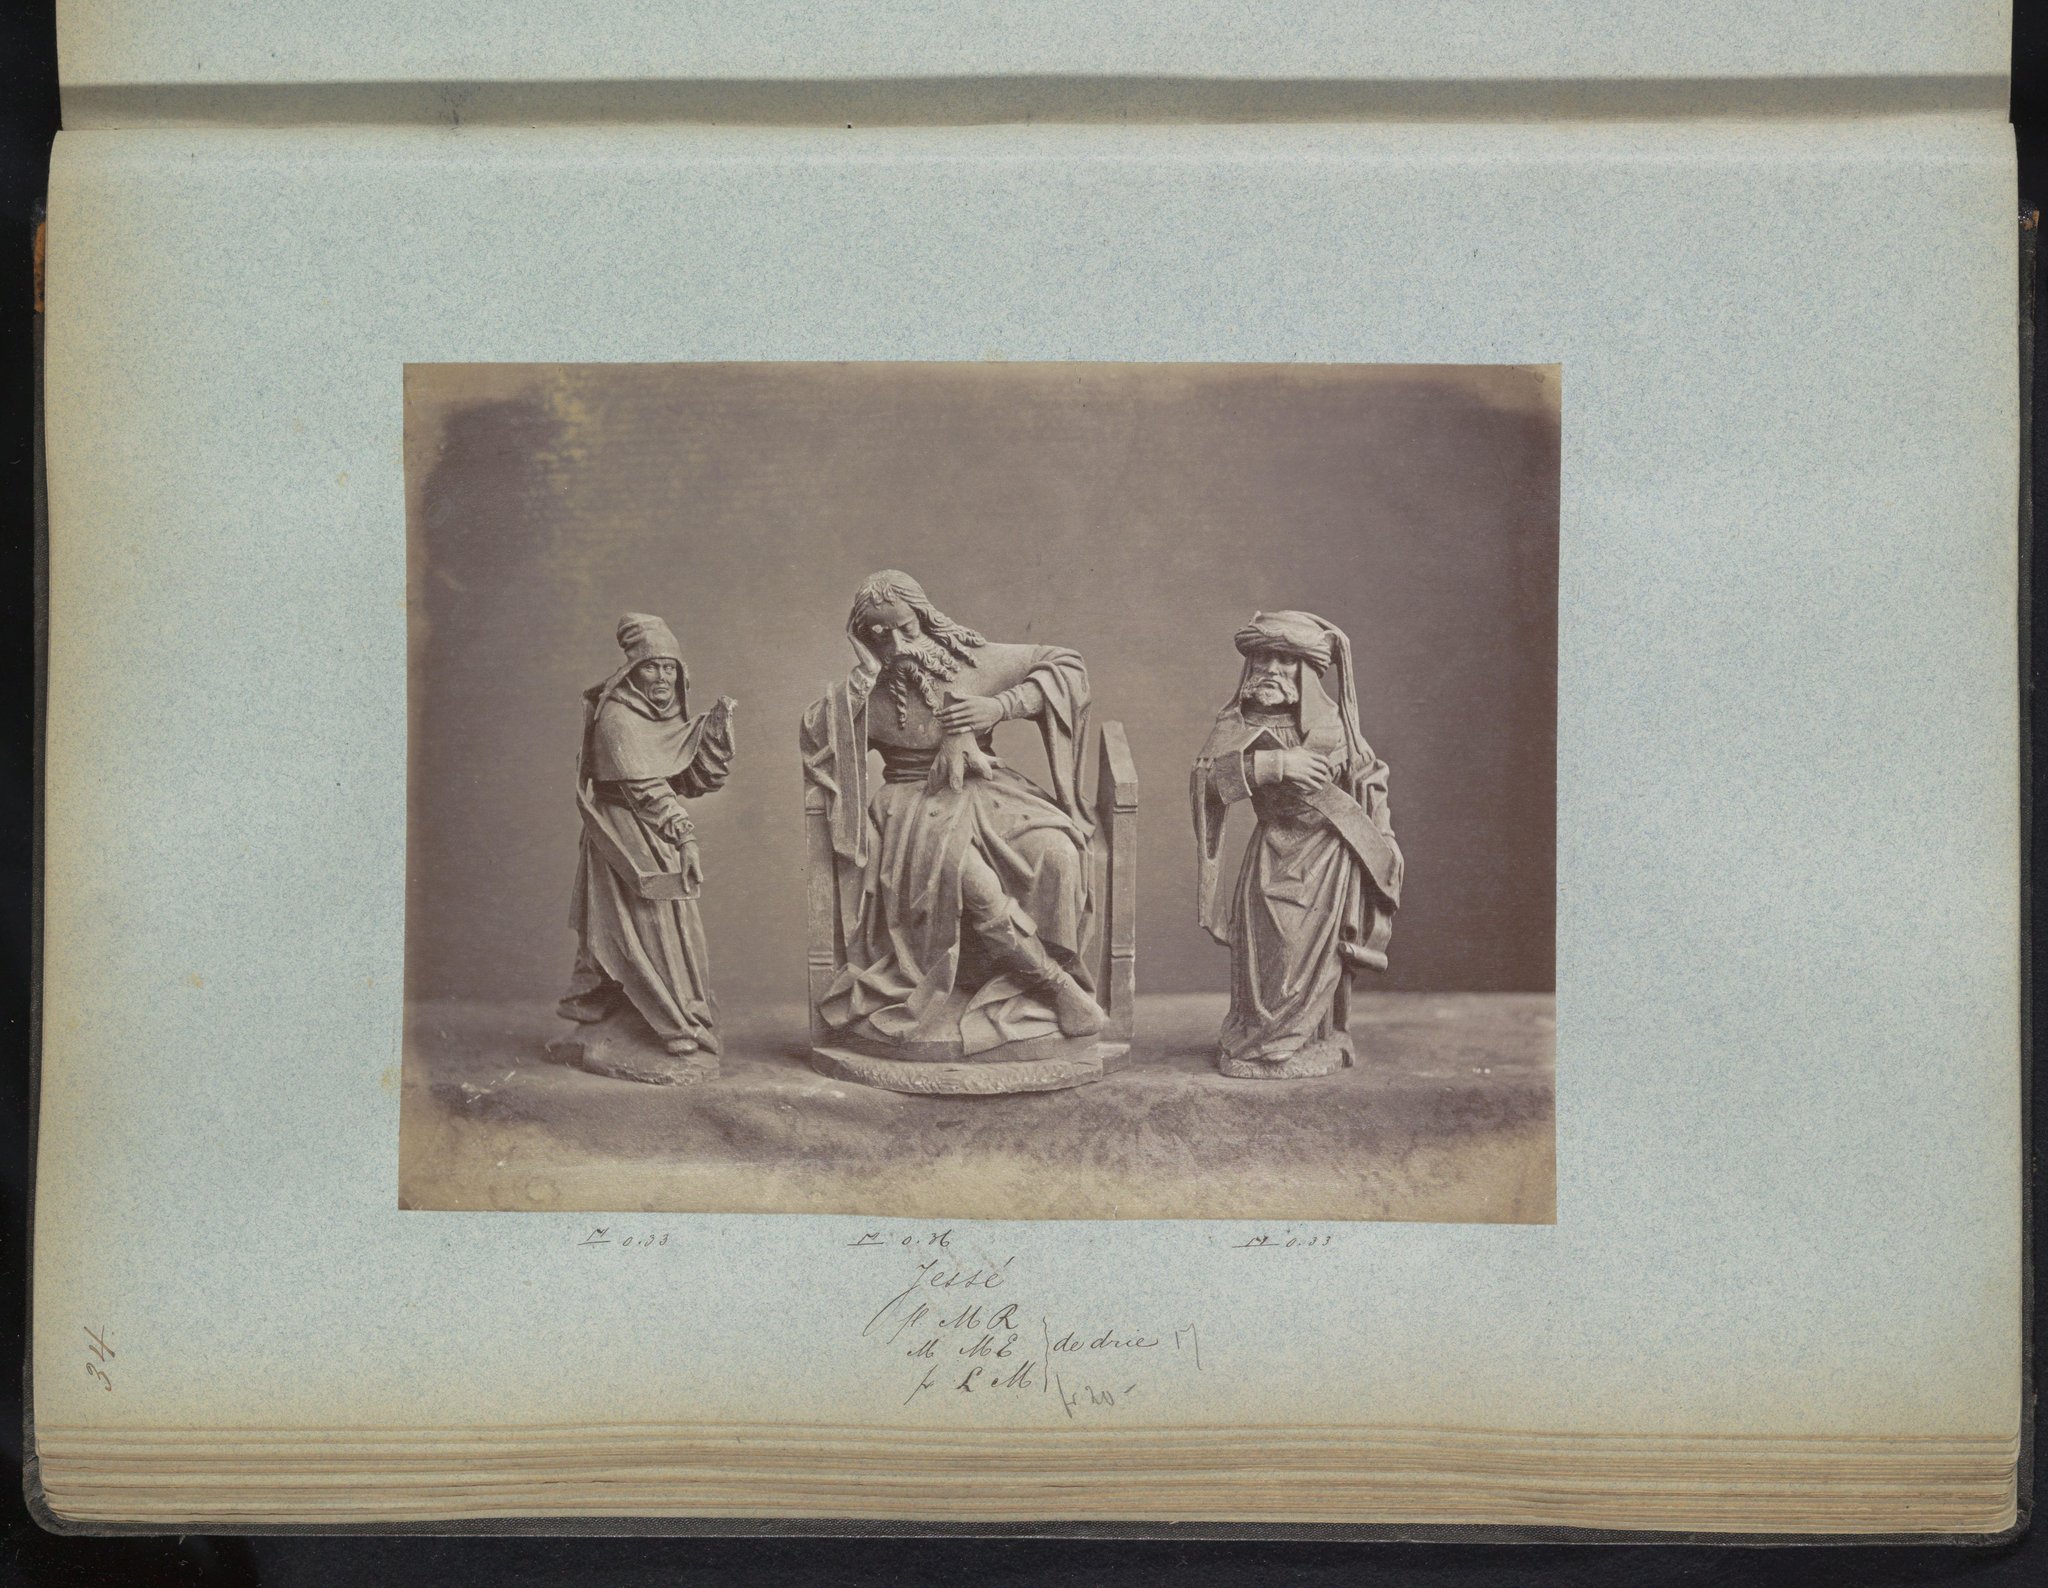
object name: album leaf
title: Drie sculpturen van religieuze figuren met in het midden de heilige Jesse van Bethlehem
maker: Anonymous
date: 1875-1900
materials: paper, photographic support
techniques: albumen print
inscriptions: annotation, annotation: ‘M 0.33 M 0.36 M 0. 33’, annotation: ‘Jesse’